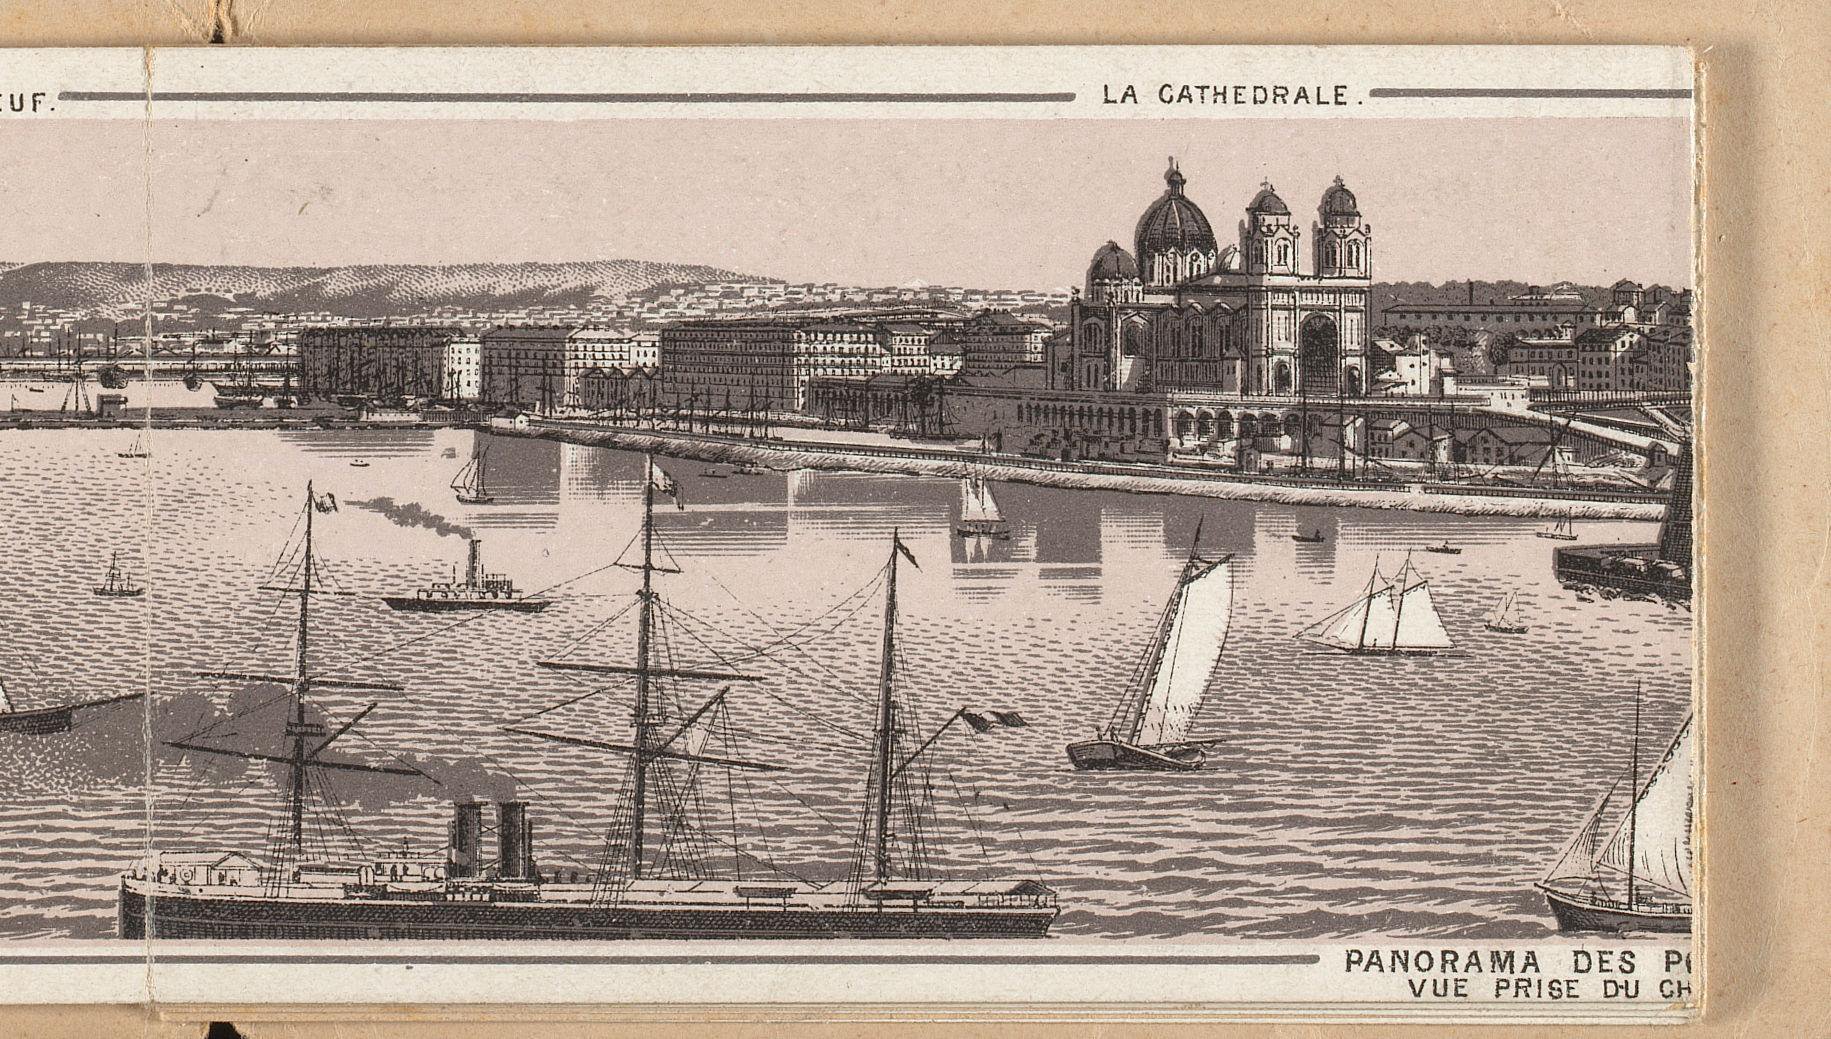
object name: print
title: Panorama des Po(rts de Marseille), Vue prise du Ch(ateau du Pharo)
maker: Anonymous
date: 1890-1910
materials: cardboard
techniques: lithograph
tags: sailing-ship, sailing-boat, church (exterior), prospect of city, town panorama, silhouette of city, marseille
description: Deze voorstelling vormt samen met drie andere voorstellingen uit dit album een panorama. De overige voorstellingen van dit leporelloalbum staan op zichzelf.